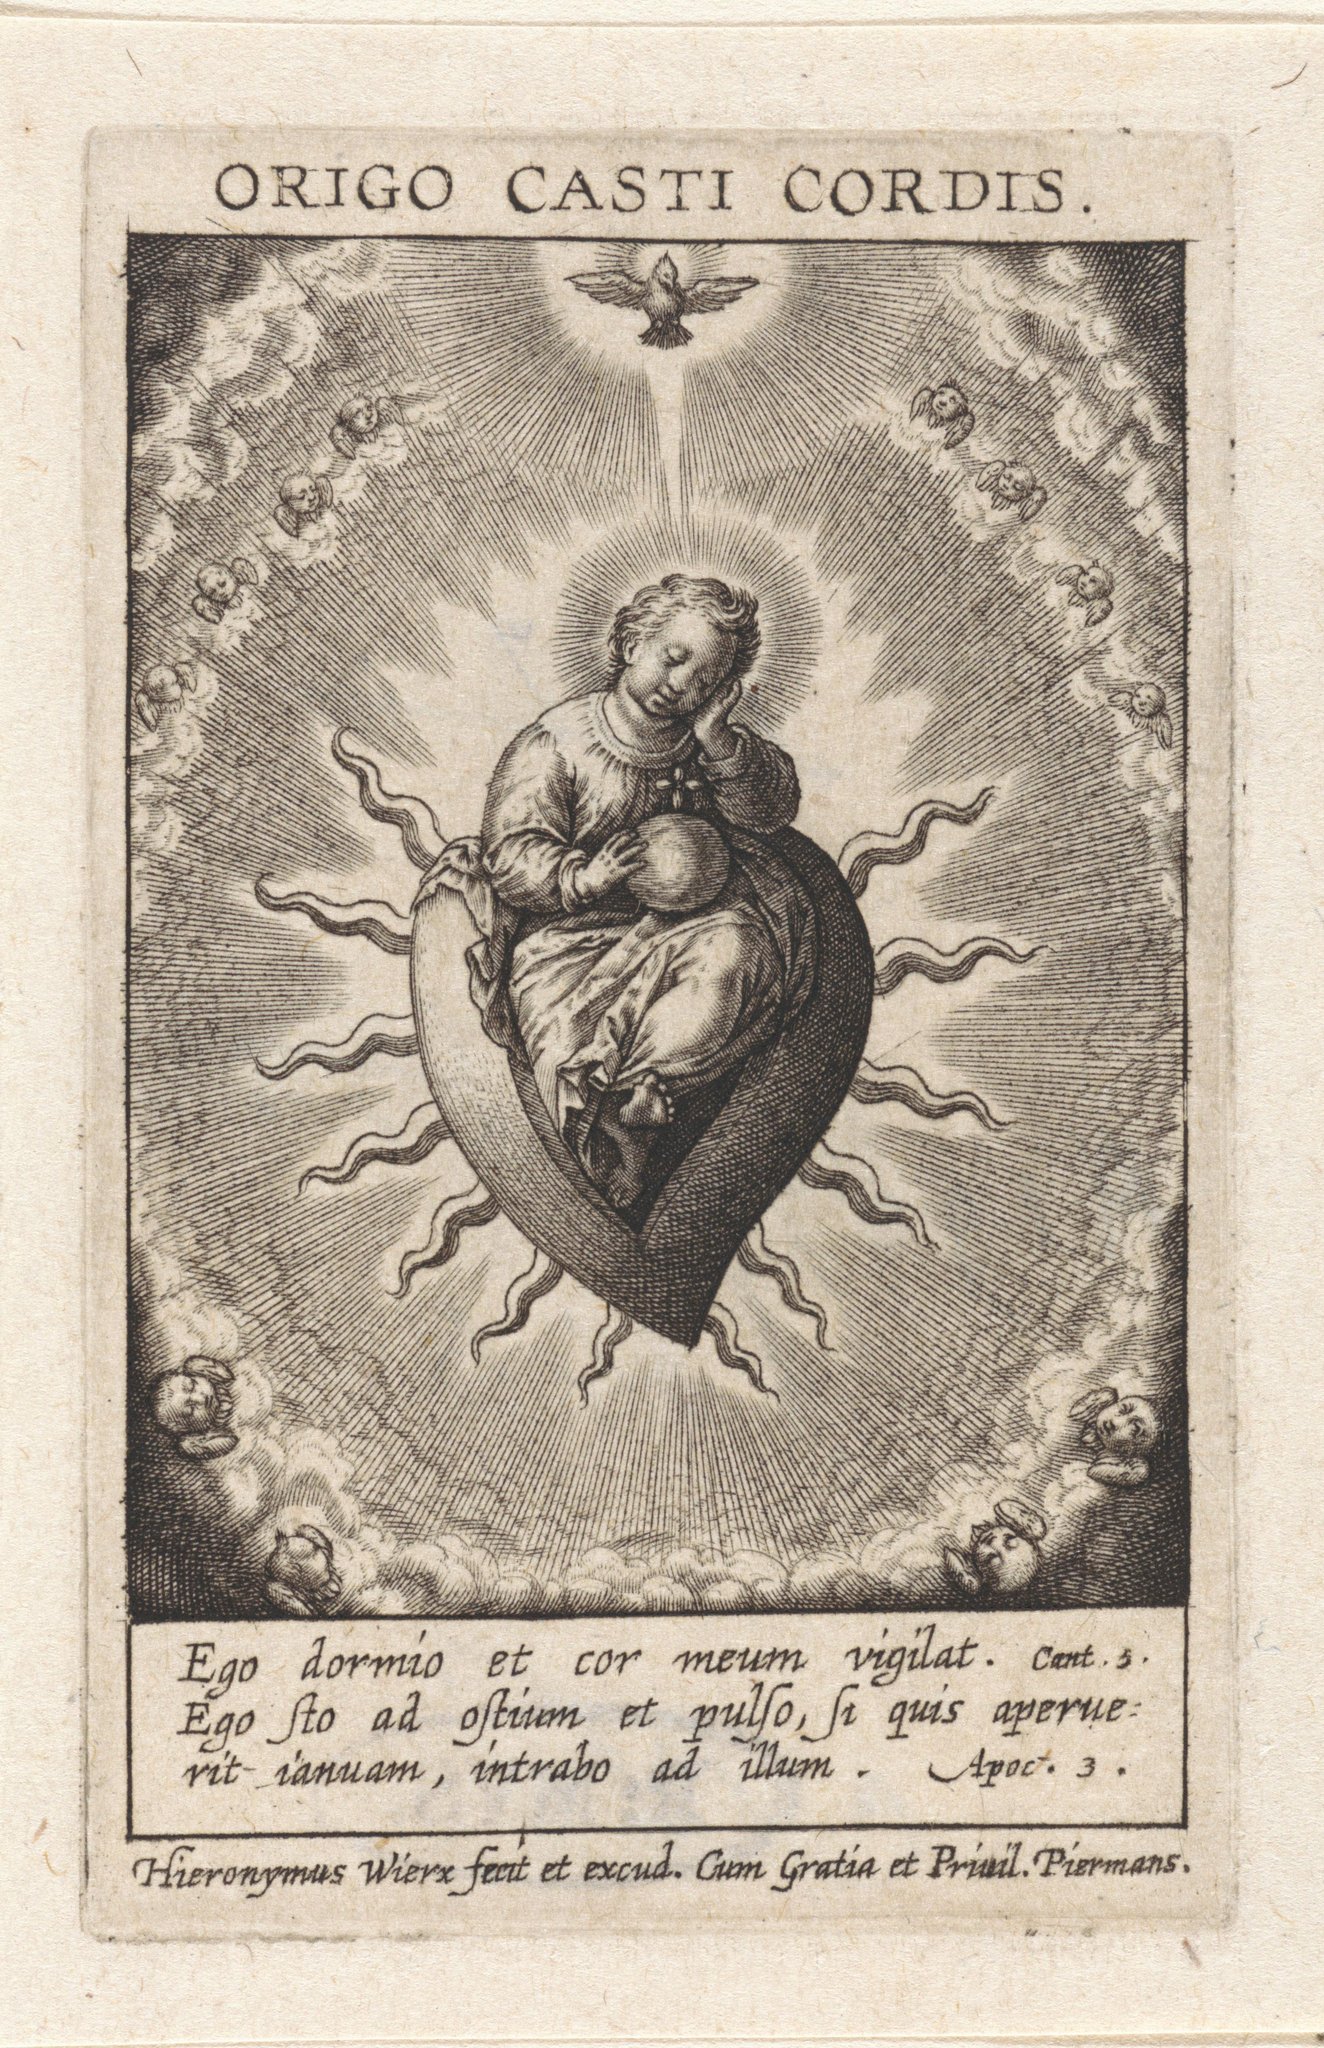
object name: print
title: Origo casti cordis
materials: paper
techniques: engraving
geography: antwerp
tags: christ-child (with attributes), holy ghost represented as a dove (in flames)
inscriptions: collector's mark: Lugt 2228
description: Het slapende Christuskind zit op een vlammend hart, omringd door cherubijnen. Bovenaan de Heilige Geest in de gedaante van een duif. In de marge een drieregelig Bijbelcitaat uit Op. 3 in het Latijn.